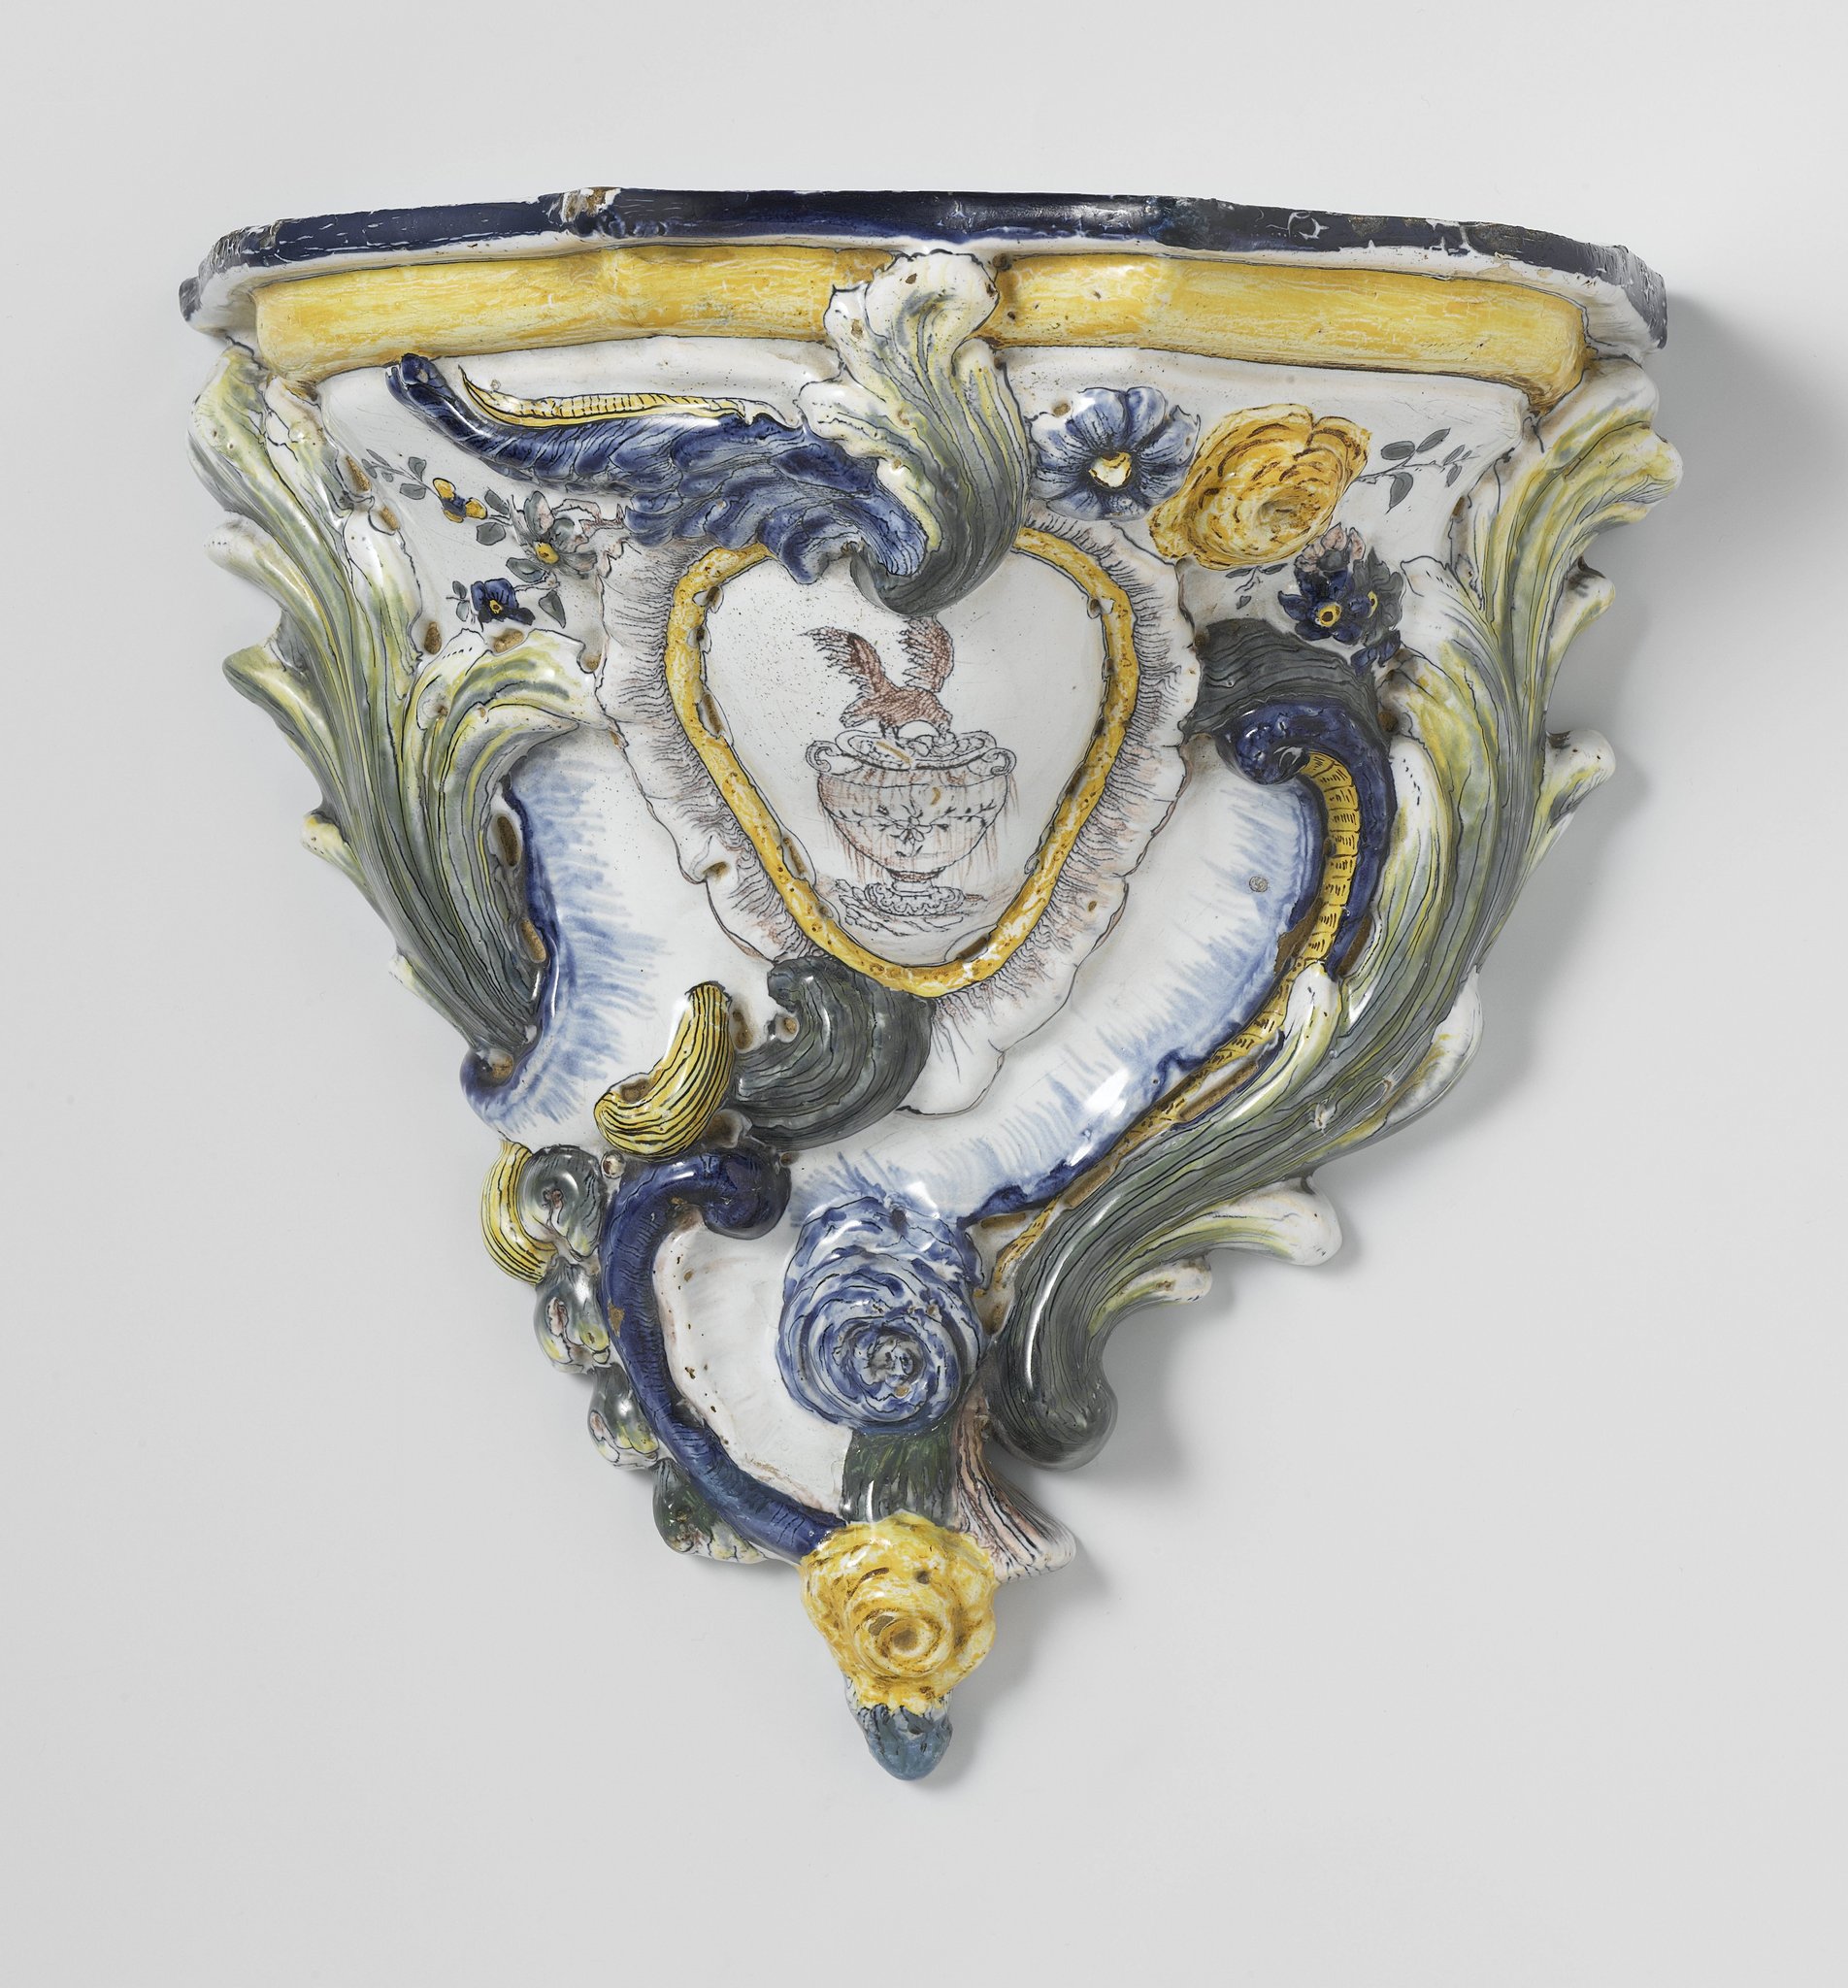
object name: console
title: Console, veelkleurig beschilderd met vogel die vruchten uit een vaas pikt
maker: Anonymous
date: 1775-1850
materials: earthenware, glaze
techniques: painted, polychromy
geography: western europe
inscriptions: collector's mark: ‘2560’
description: Console van veelkleurig beschilderde faience. In een omgekeerd peervormig medaillon in relief is een vogel geschilderd die vruchten uit een vaas pikt. Om het medaillon heen zijn bladeren en bloemen in relief gemodelleerd. De console is beschilderd in de kleuren blauw, groen, geel en paars.